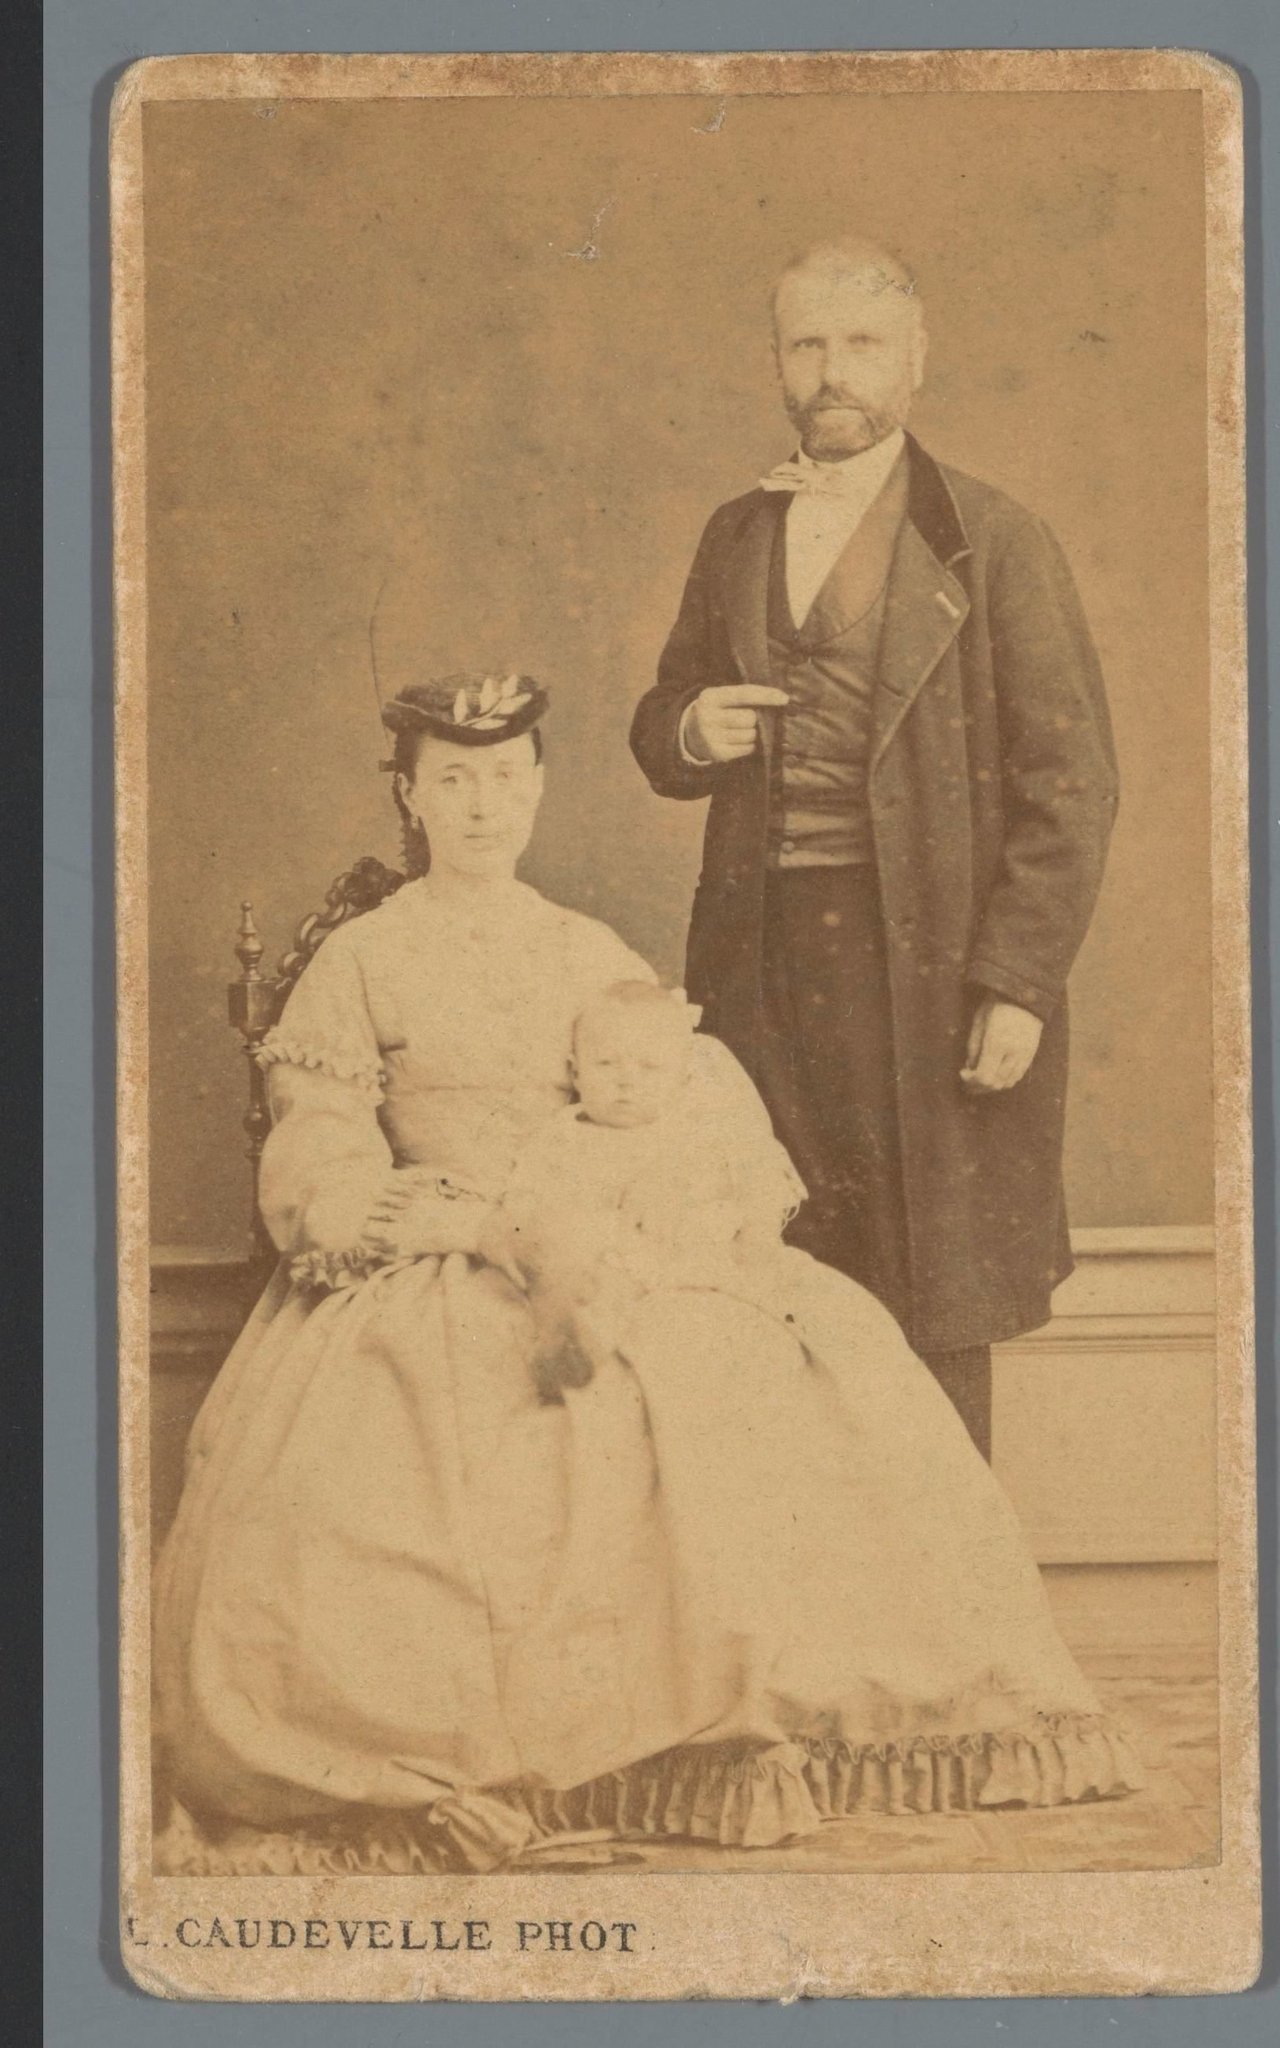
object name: carte de visite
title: Portret van een onbekend echtpaar met kind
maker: louis caudevelle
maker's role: fotograaf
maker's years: 1834-1890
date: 1861-1885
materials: cardboard, paper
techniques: albumen print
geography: boulogne-sur-mer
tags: family group, especially parents with their child(ren), anonymous historical person portrayed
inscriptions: inscription: ‘L. Caudevelle phot.’, inscription: ‘L. Caudevelle/ Phpotographe/ Rue des Carreaux, 7./ En face la Poste aux Lettres/ Boulogne-s/Mer.’